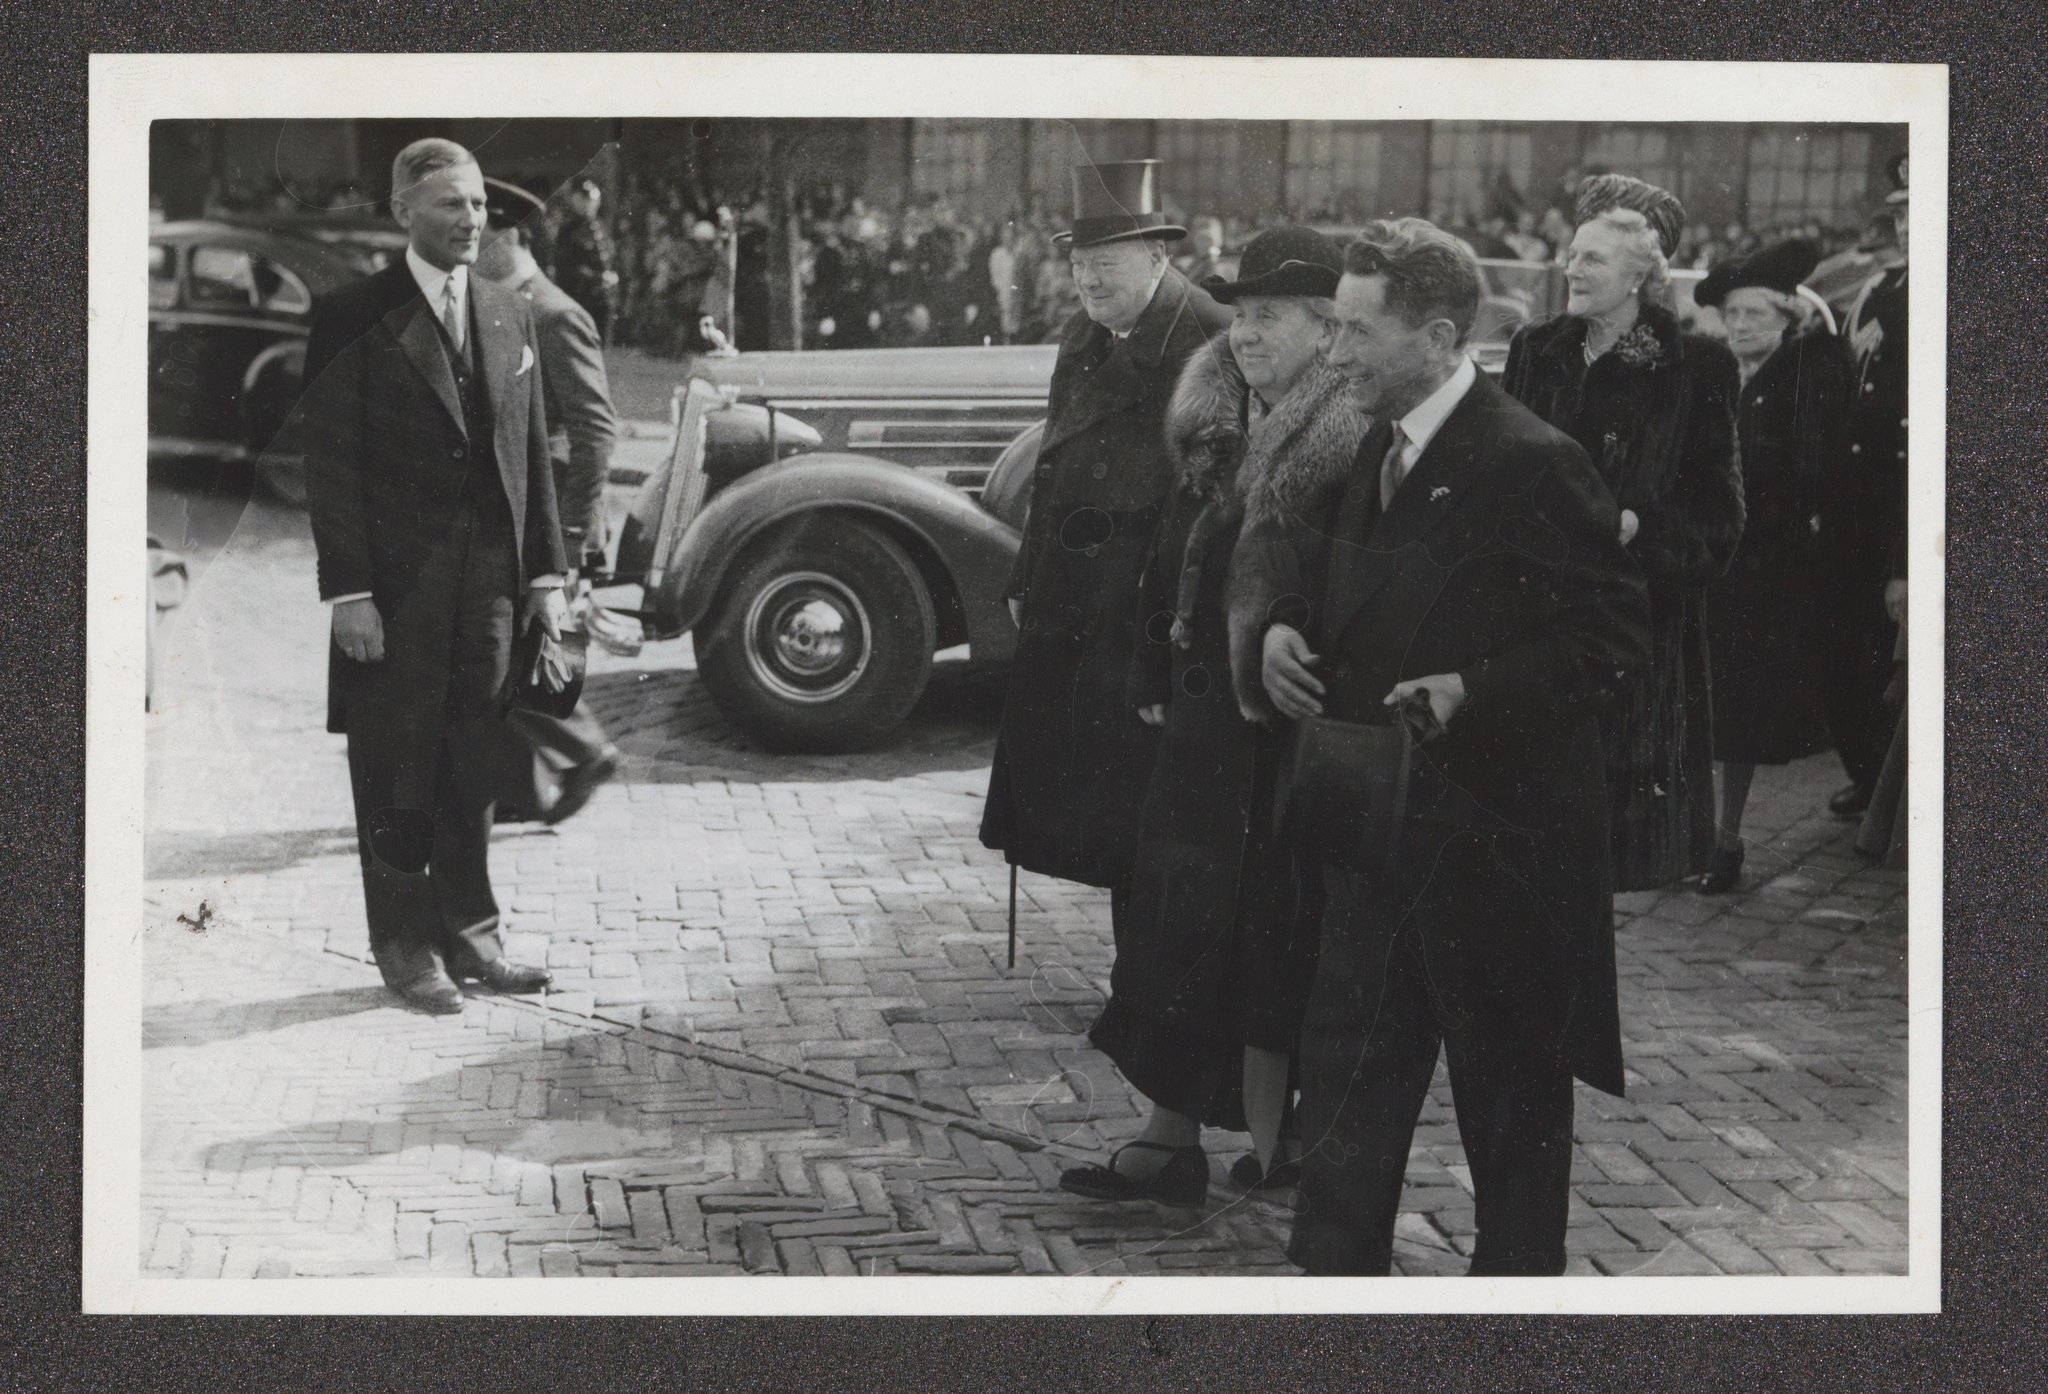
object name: photograph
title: Koningin Wilhelmina Mr. Churchill en Wethouder Schokking op de De Ruyterkade in Amsterdam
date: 1946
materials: paper, photographic support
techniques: gelatin silver print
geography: amsterdam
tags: print maker, wilhelmina of the netherlands, london, amsterdam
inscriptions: annotation: ‘No 17396 foto Anefo/Raucamp copyright Anefo Amsterdam’, stamp: ‘Copyright ANEFO’, annotation: ‘Hedenmiddag vond op de de Ruyterkade ... achter Churchill Mrs. Churchill’